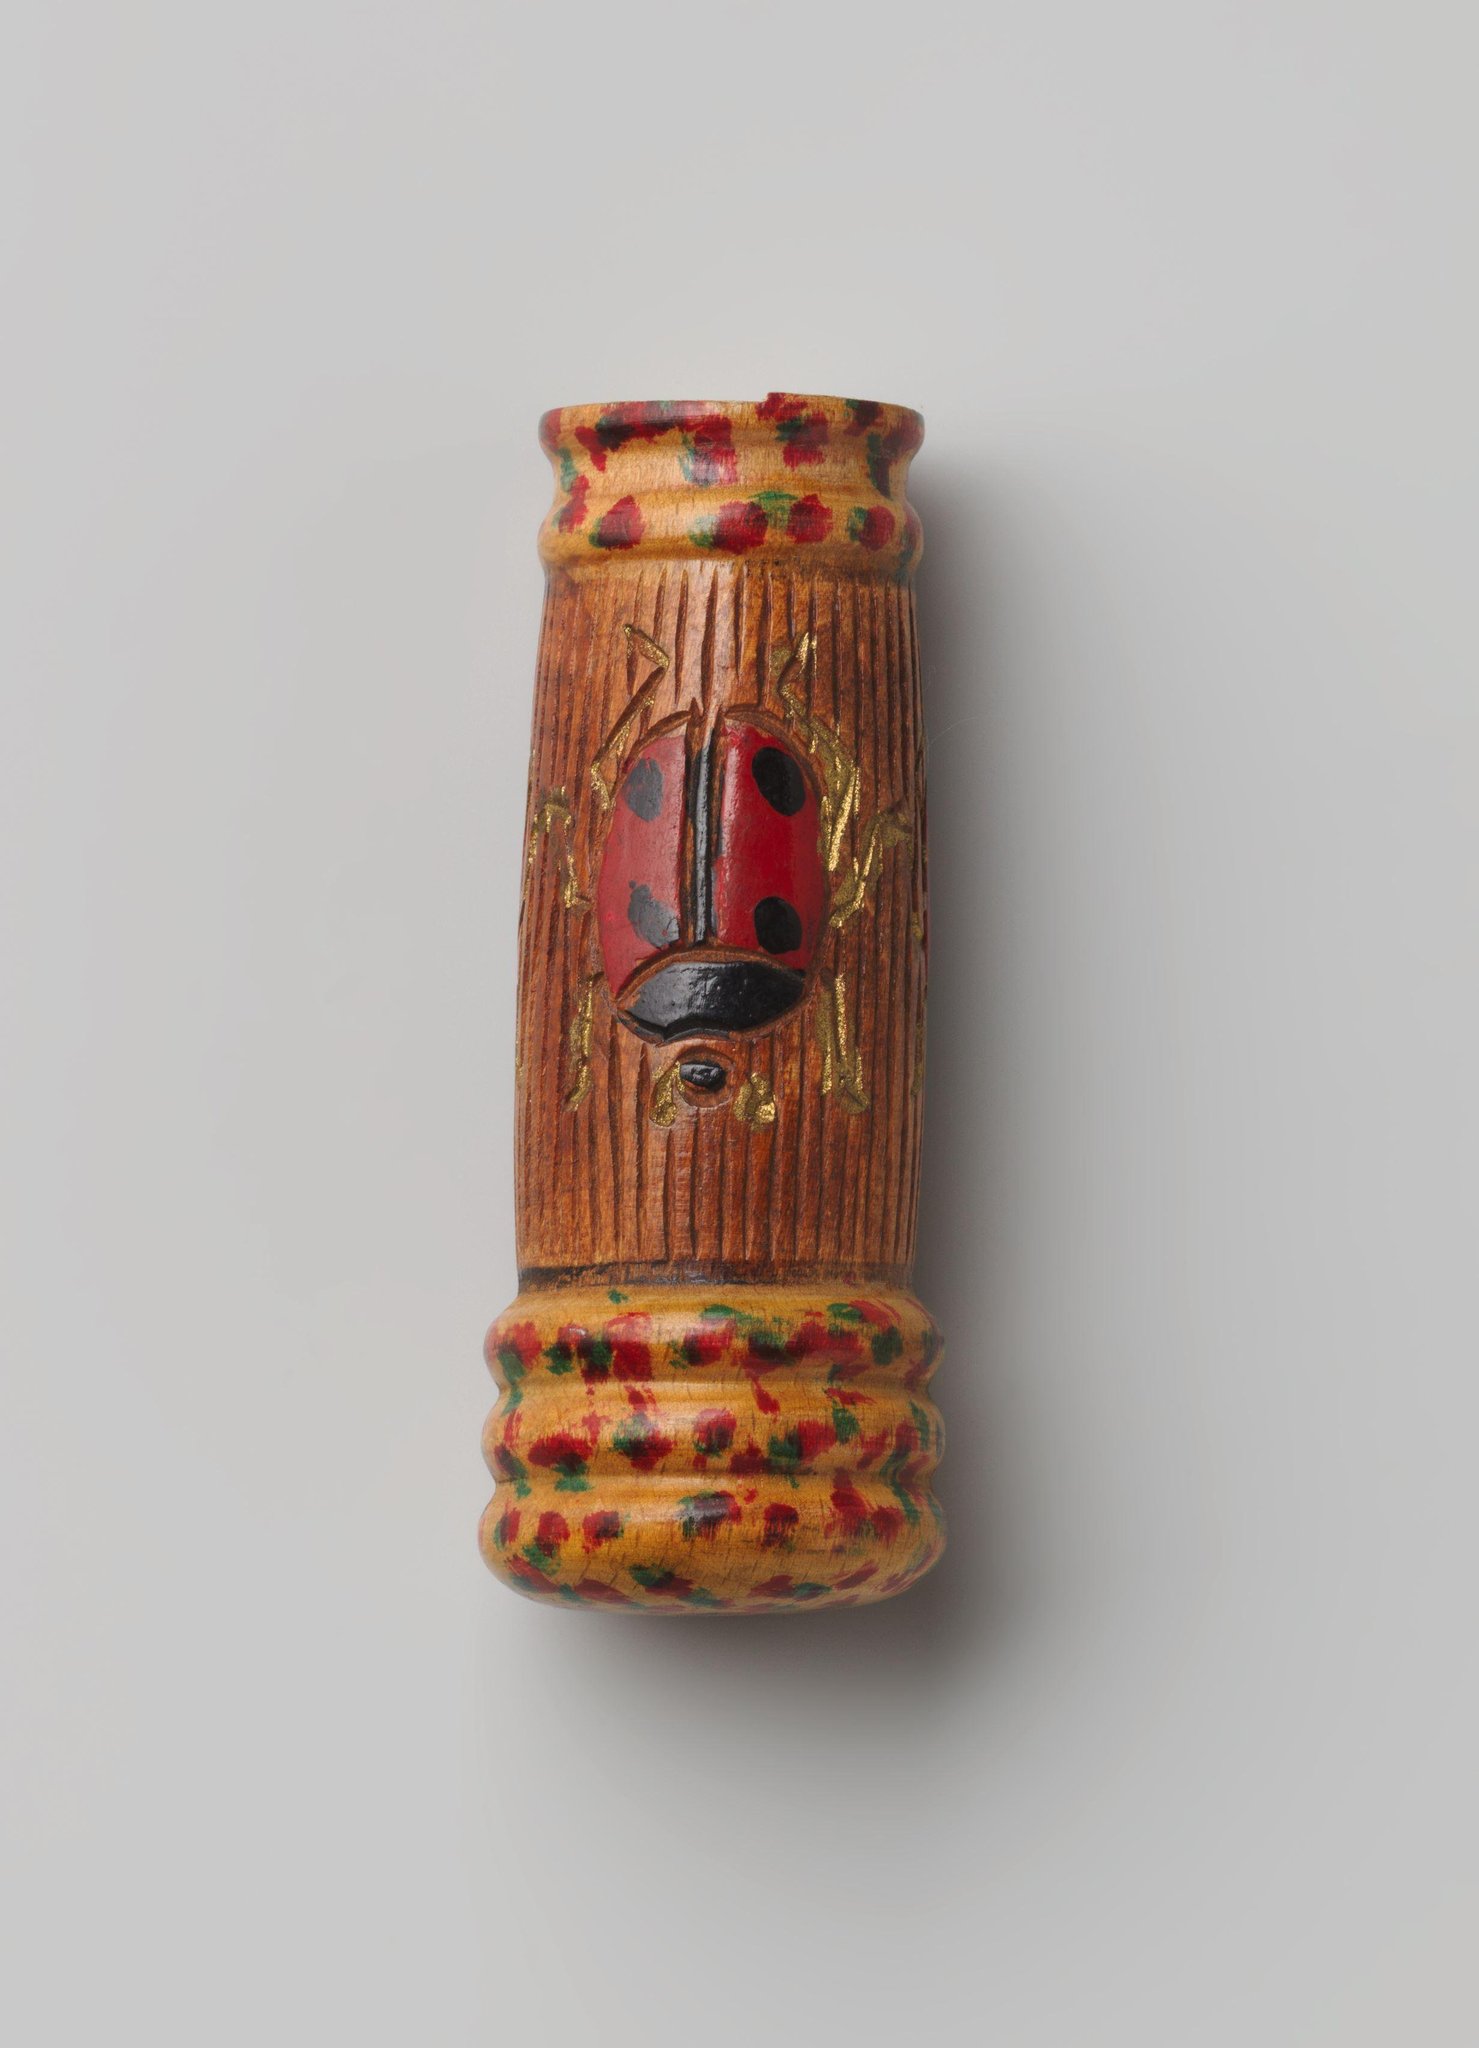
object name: parasolknop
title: Parasolknop of parapluknop van hout, versierd met in het hout gekerfde lieveheersbeestjes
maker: gustav schnitzler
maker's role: paraplufabrikant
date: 1920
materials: paint, wood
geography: nijmegen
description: Parasolknop of parapluknop van geverfd hout. De knop is versierd met in het hout gekerfde lieveheersbeestjes.